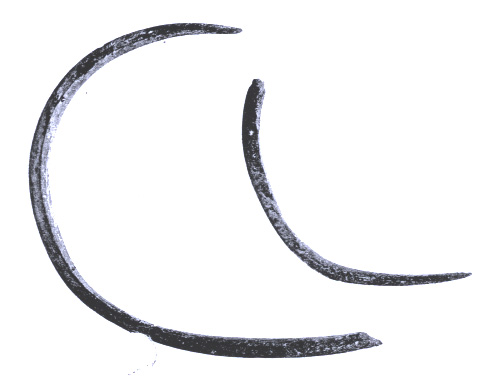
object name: bracelet fragment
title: Bracelet (?) fragments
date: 3300-3100 BCE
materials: shell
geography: egypt